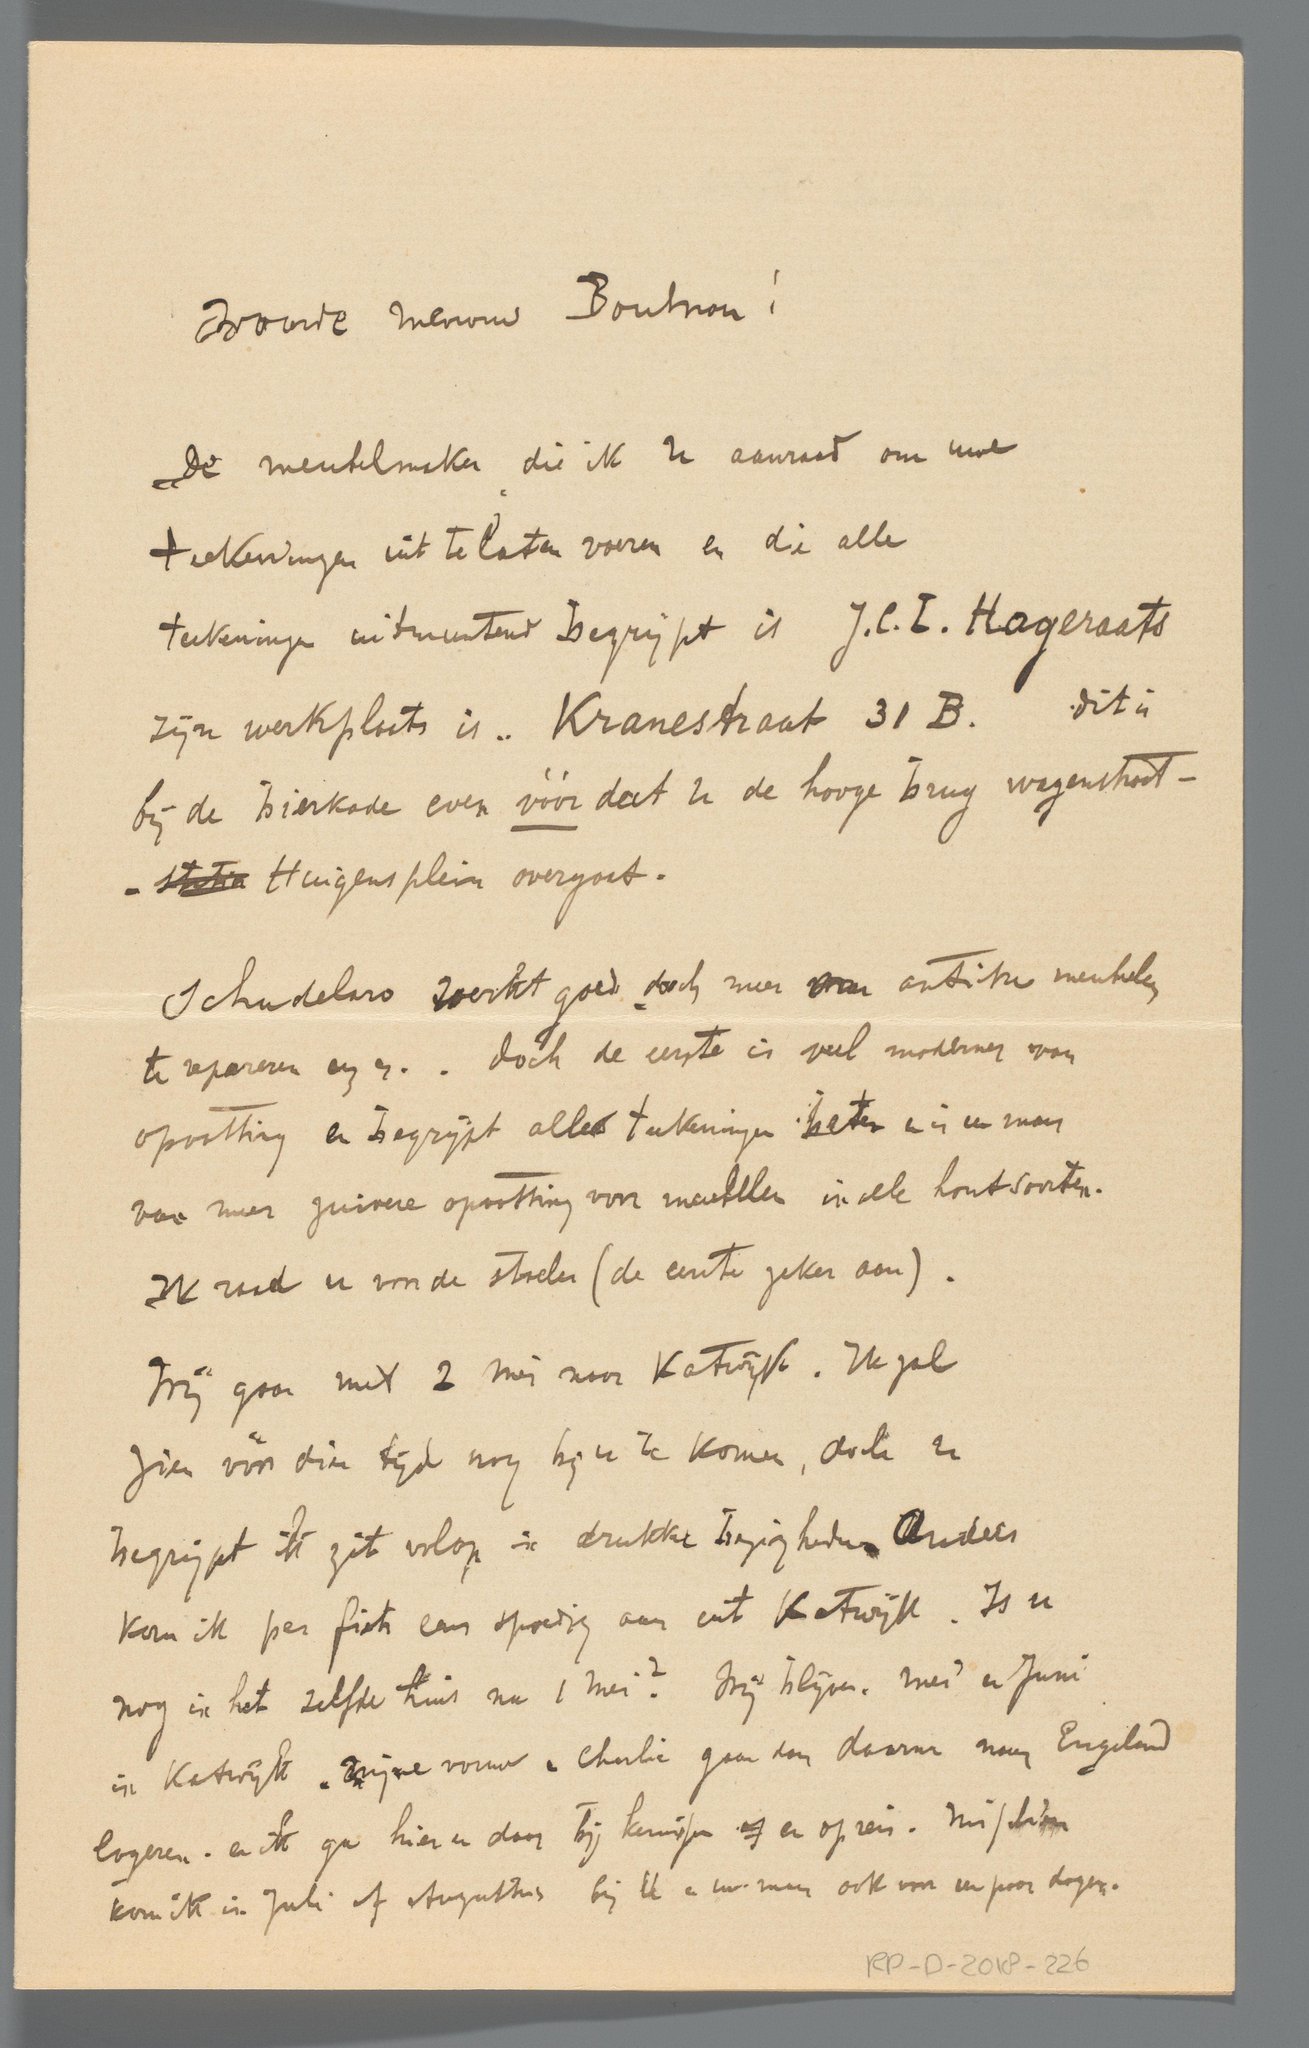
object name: letter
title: Brief aan Jeannette Bouman-Stuyling de Lange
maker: jan toorop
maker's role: draughtsman, painter, print maker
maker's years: 1858-1928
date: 1899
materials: ink, paper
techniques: pen, writing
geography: the hague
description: Brief gericht aan Mevrouw Bouman, Geb Stuyling de Lange, Villa Vineta, Scheveningen.